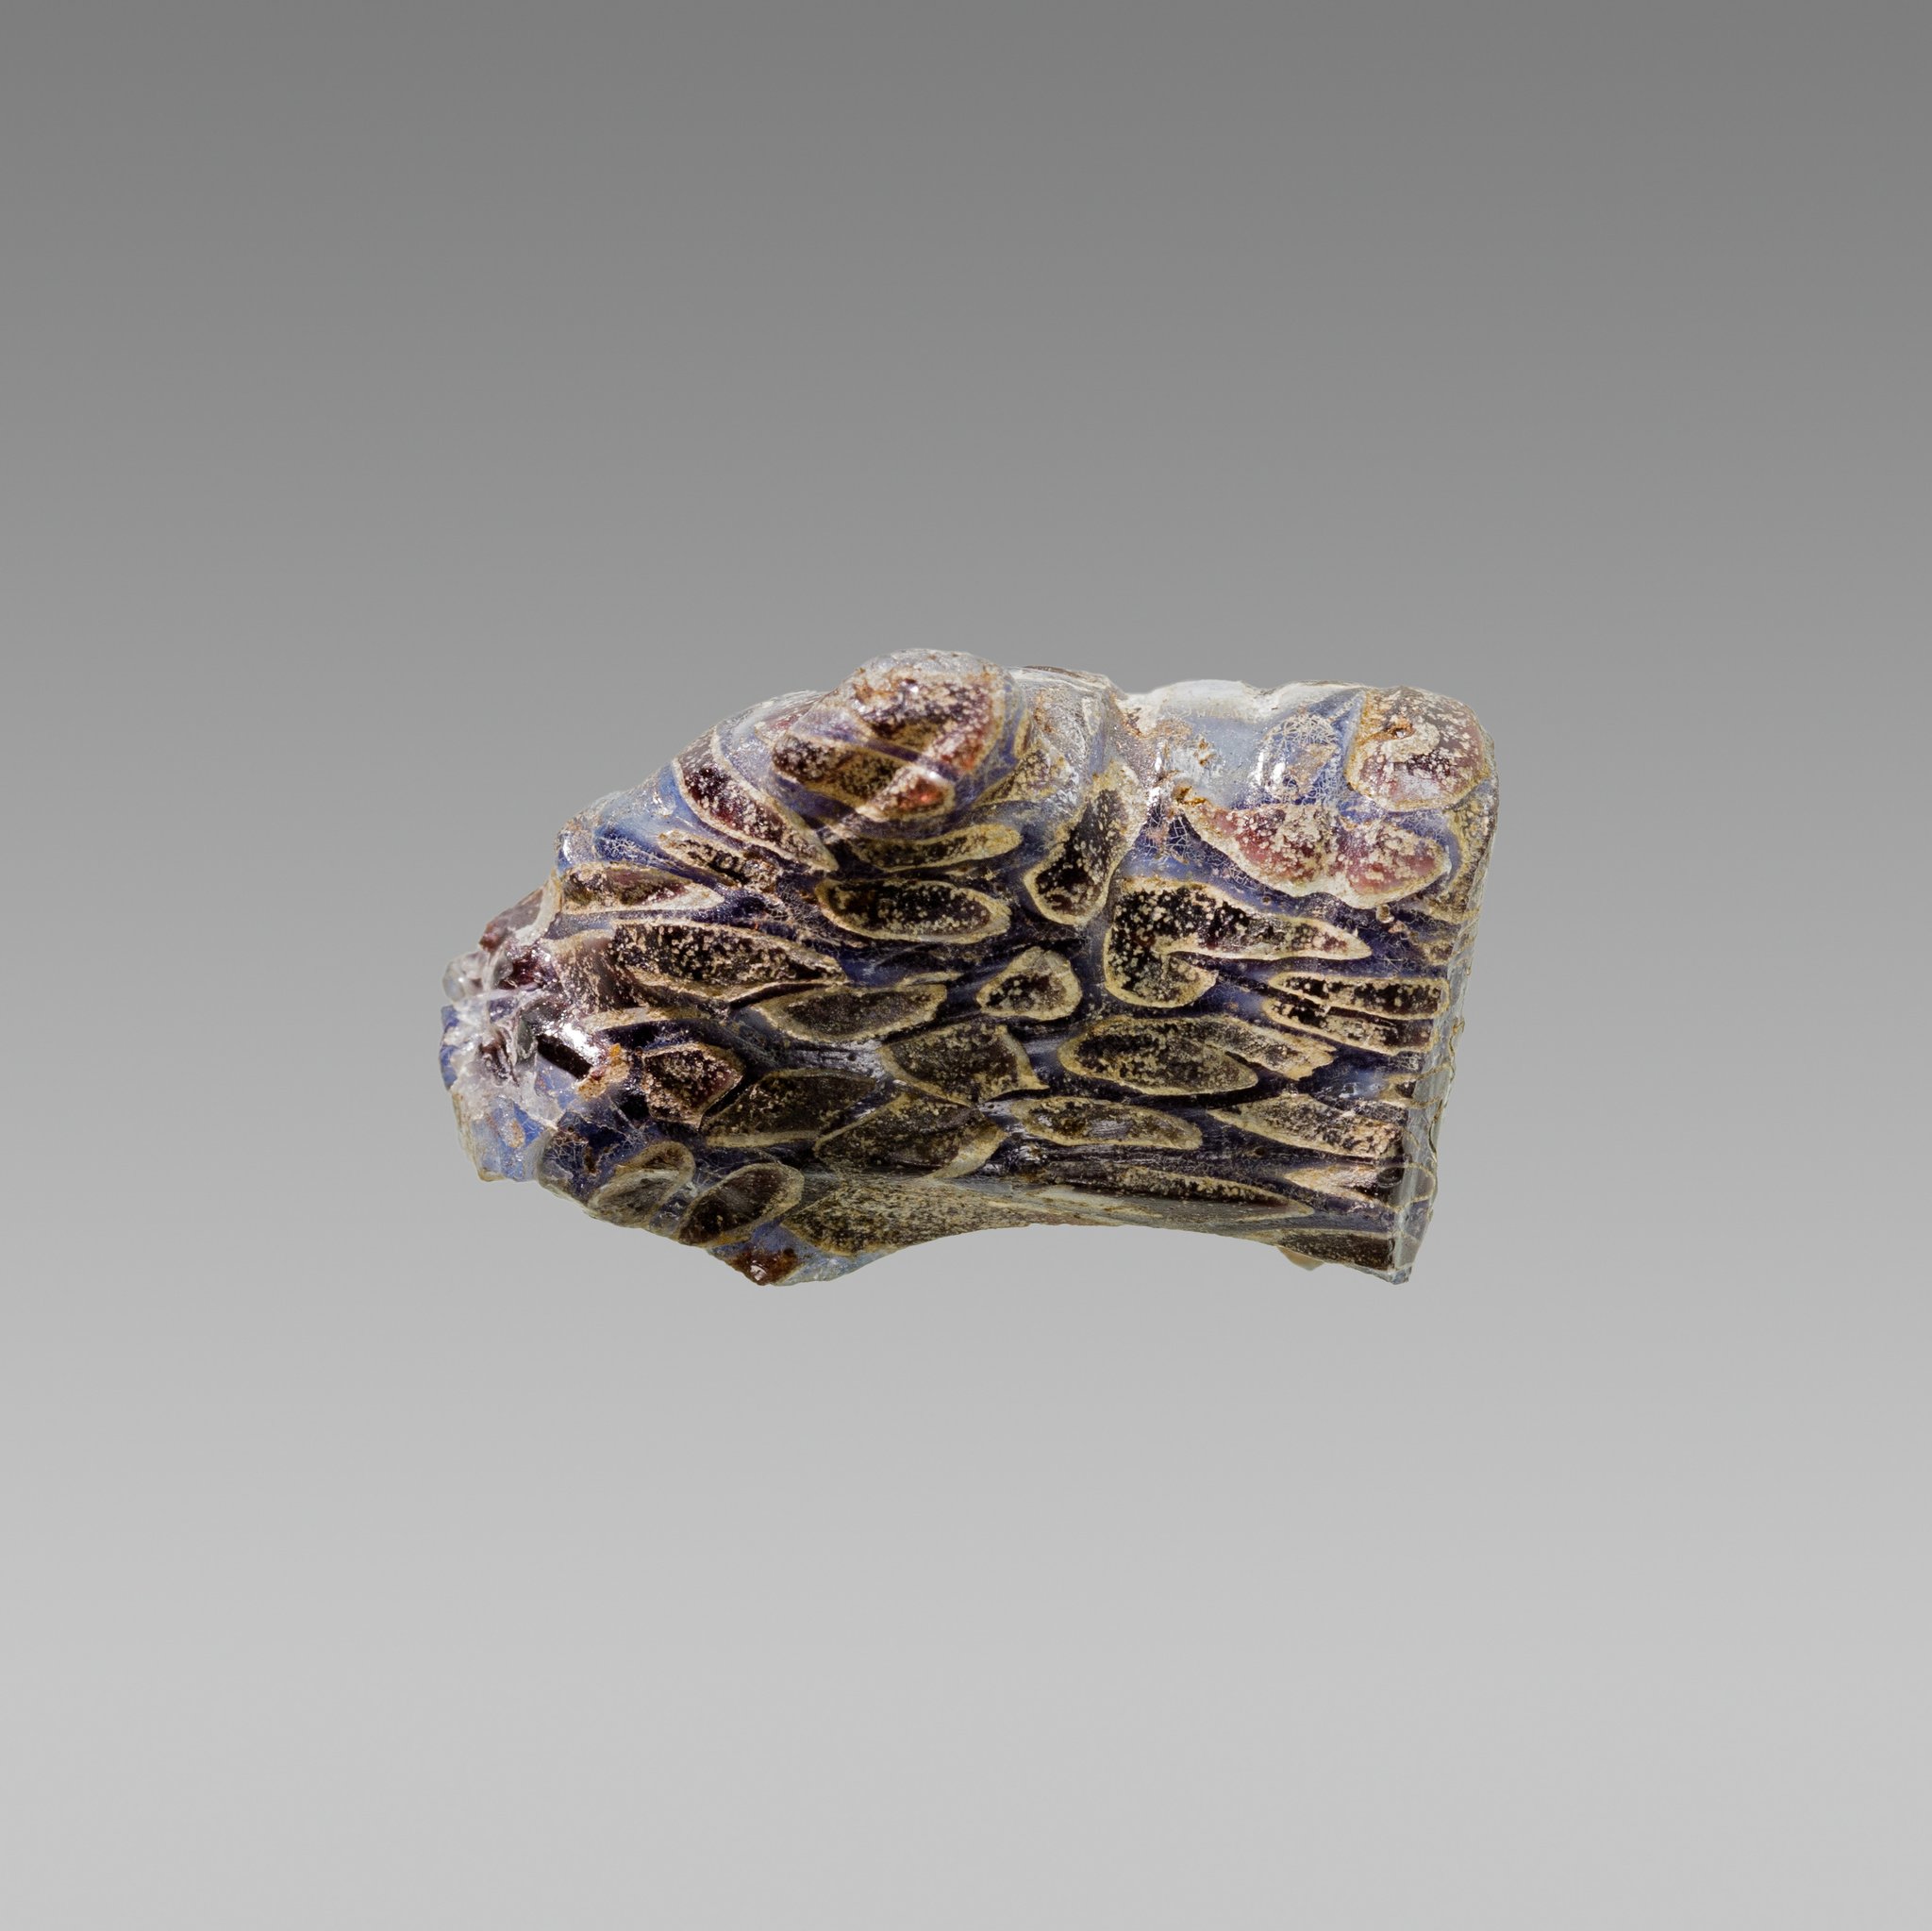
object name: figurine, animal head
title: Animal head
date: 664-630 BCE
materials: glass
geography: egypt